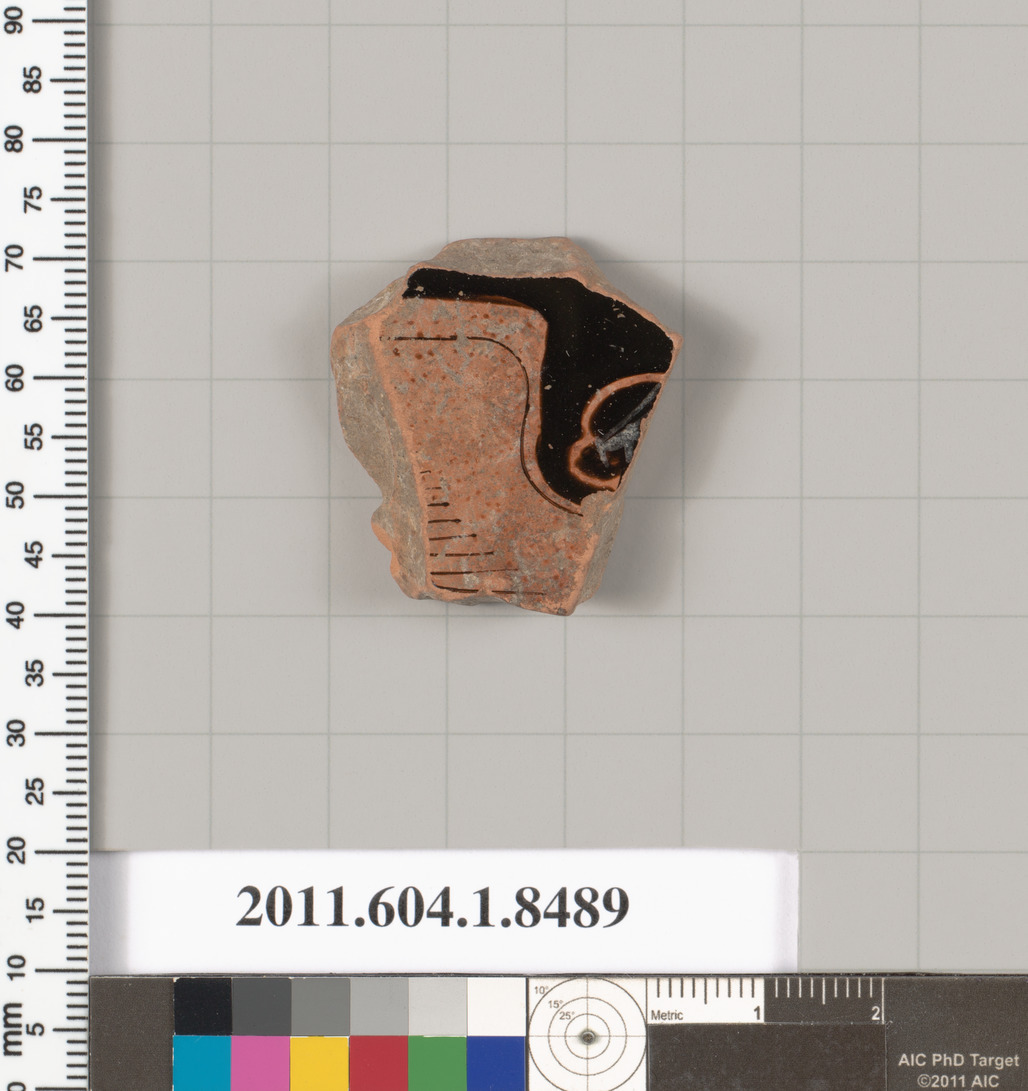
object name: kylix fragment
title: Terracotta fragment of a stemless kylix (drinking cup)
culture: greek, attic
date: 460-450 BCE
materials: terracotta